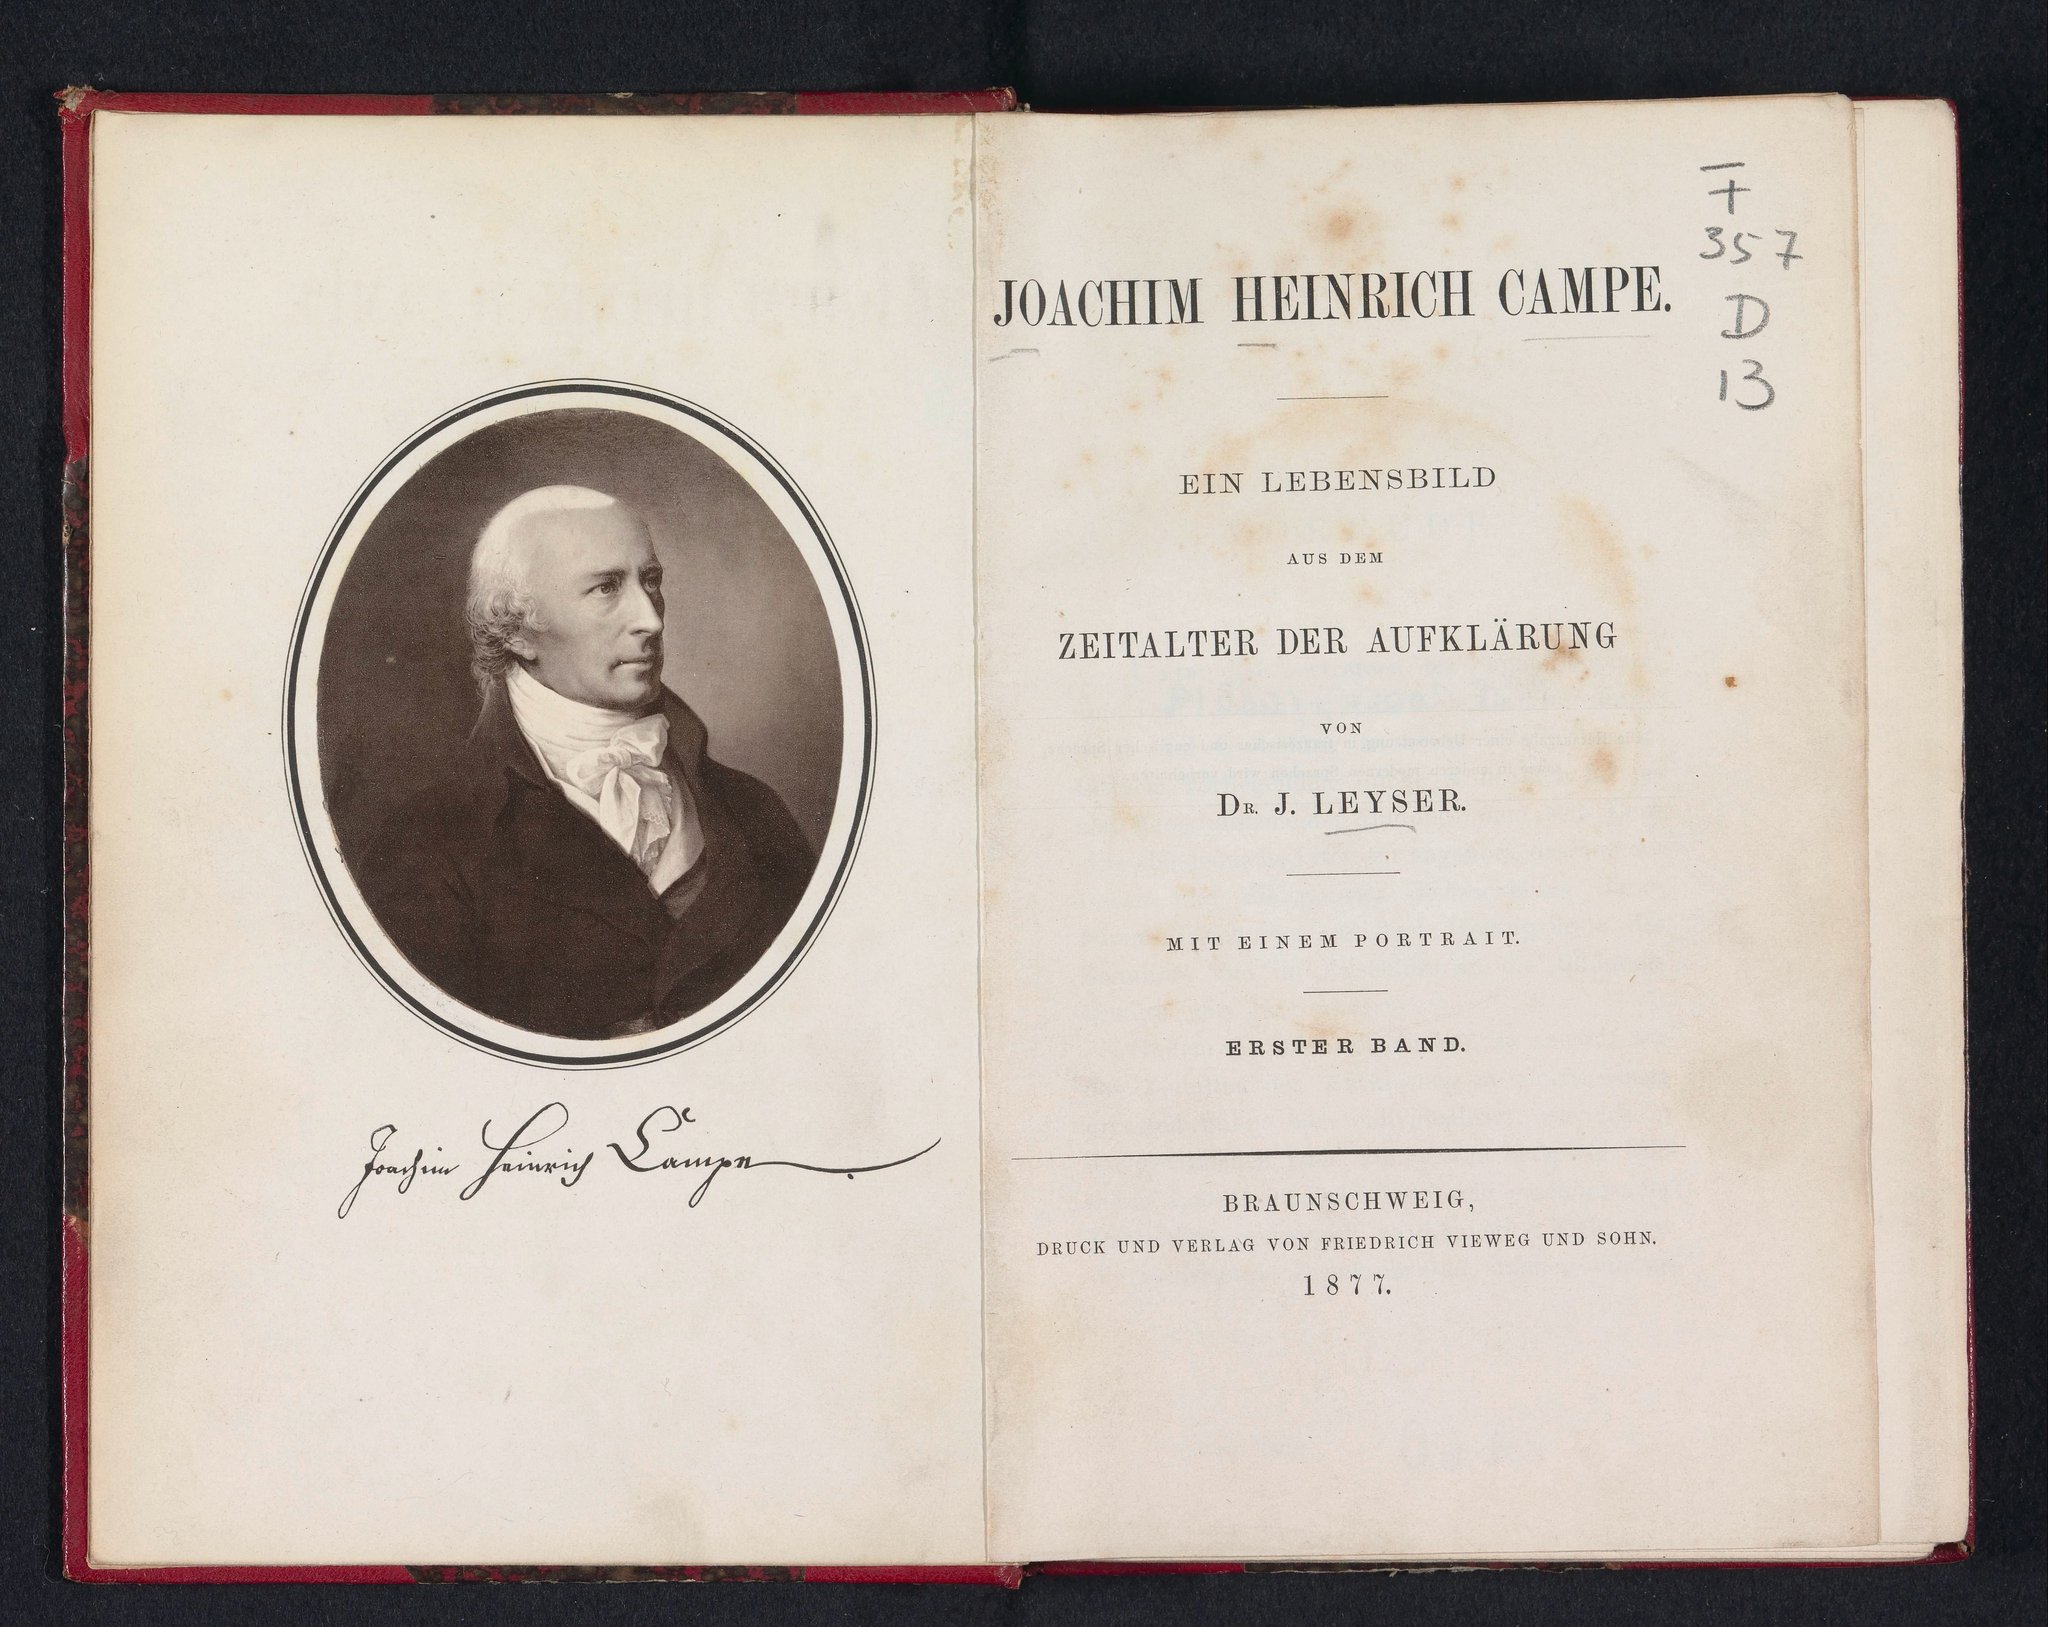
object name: page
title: Fotoreproductie van een schilderij, voorstellende een portret van Joachim Heinrich Campe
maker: Anonymous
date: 1872-1877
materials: paper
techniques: photograph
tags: joachim heinrich campe, portrait of a writer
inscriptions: name: ‘Joachim Heinrich Campe’